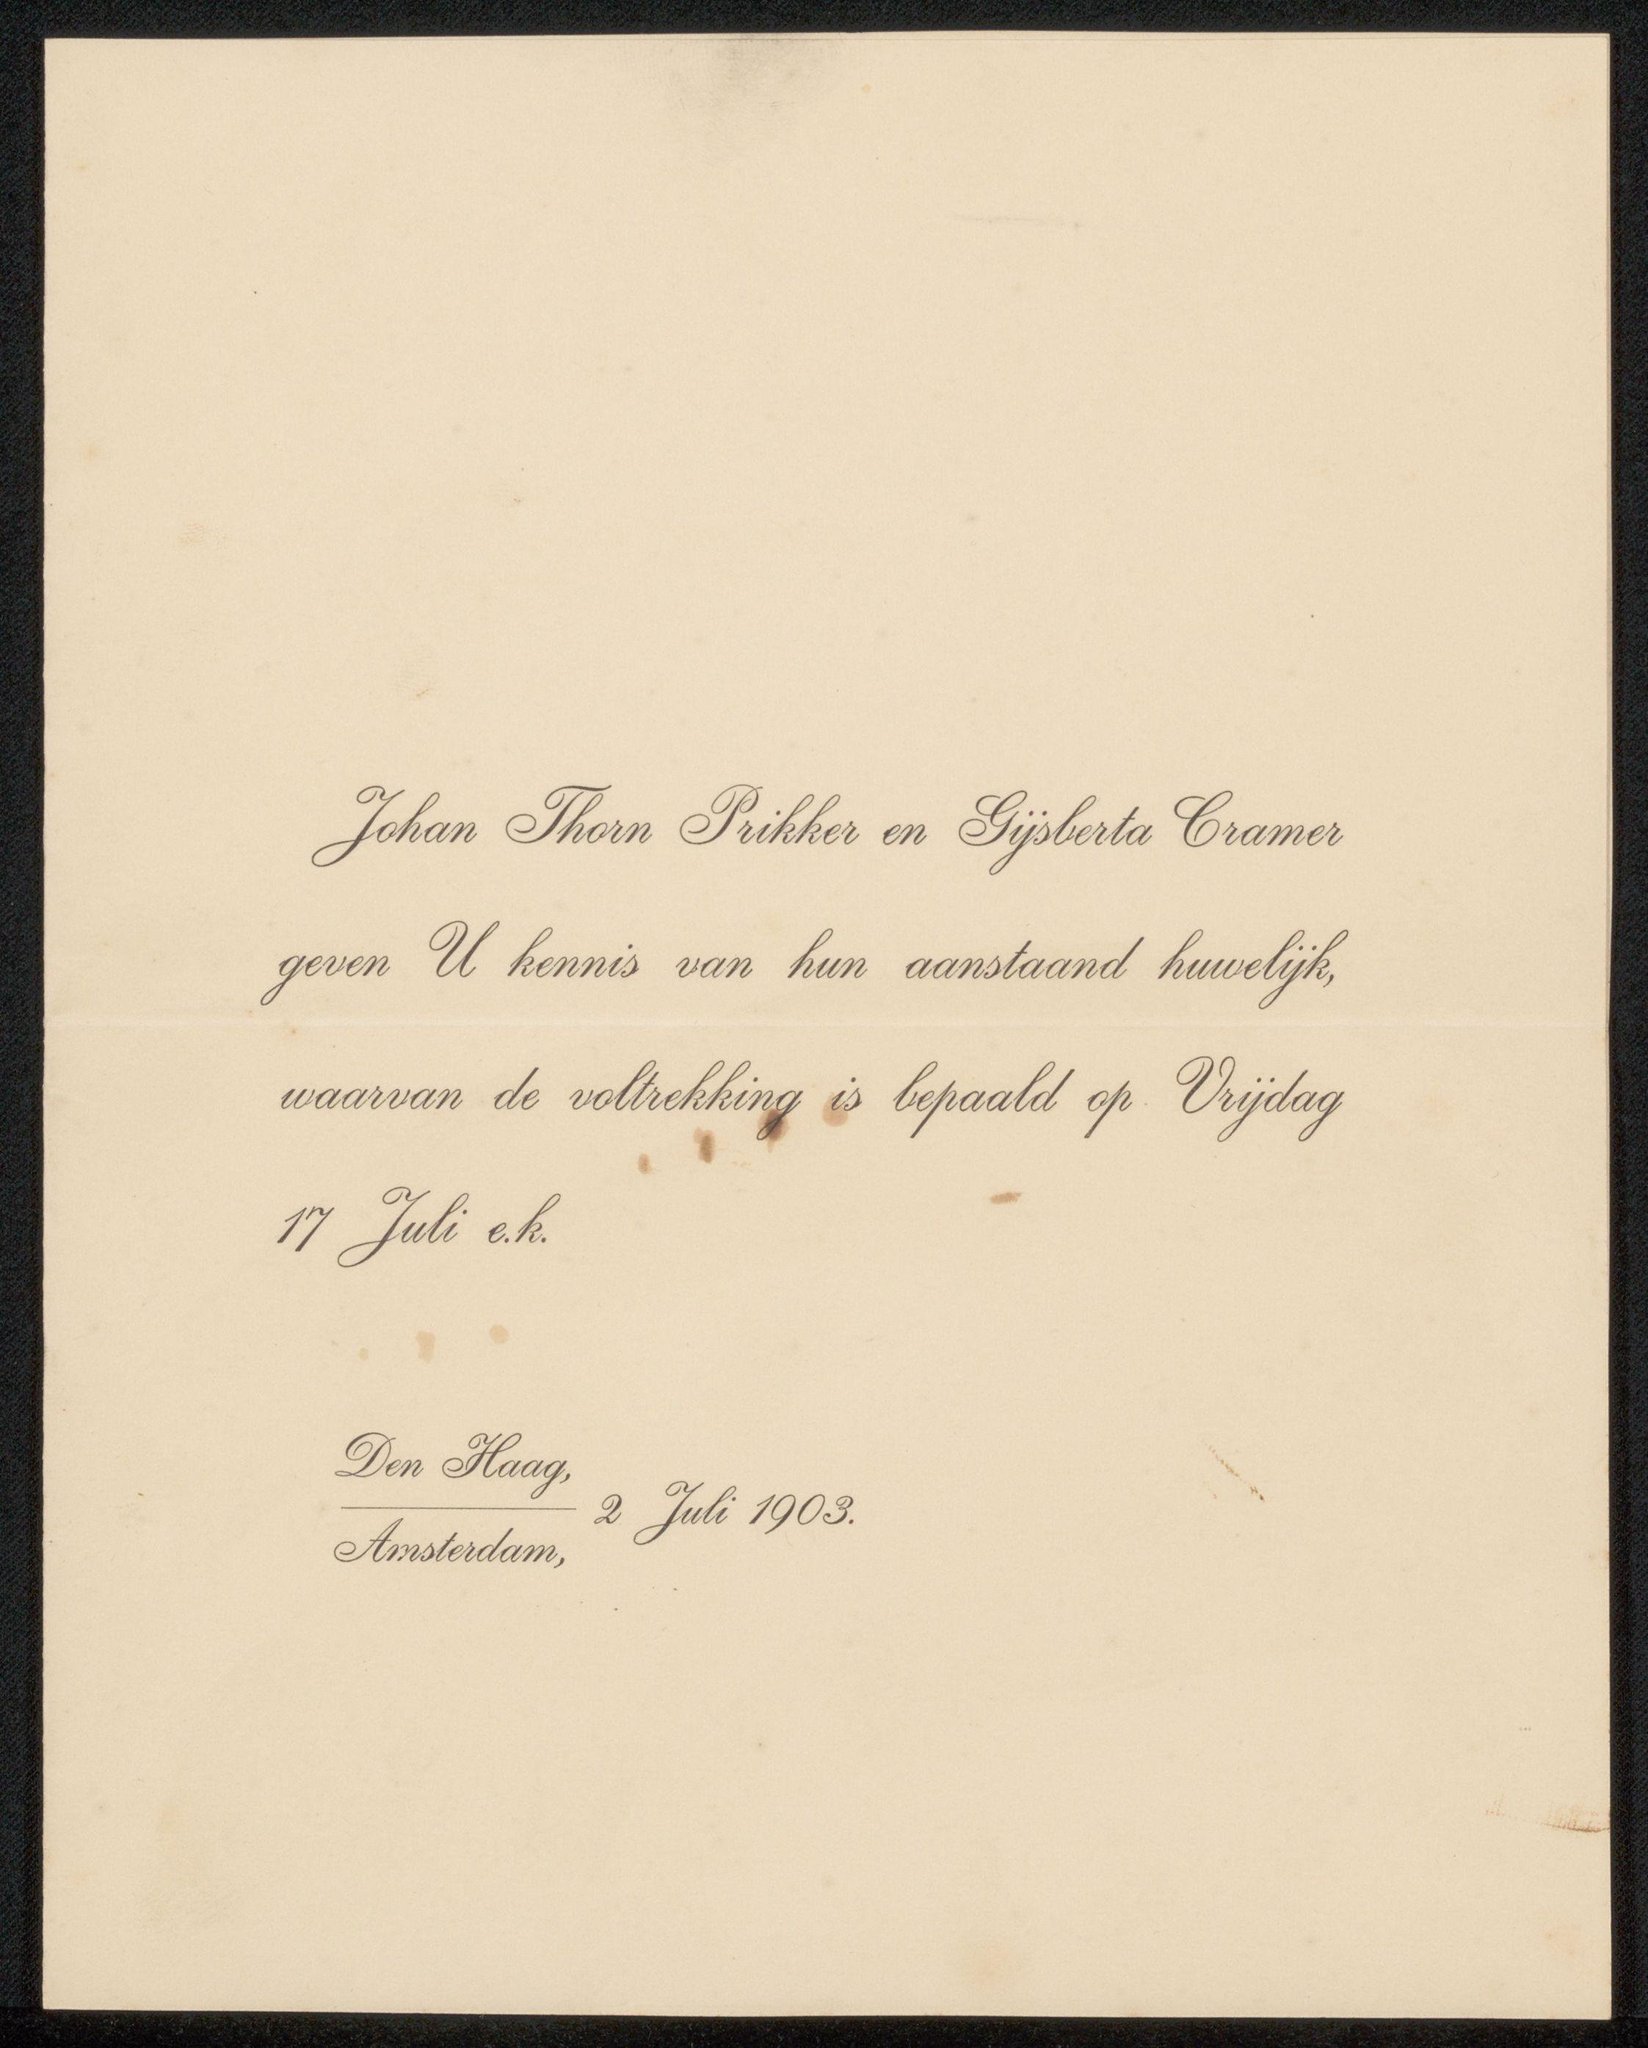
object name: wedding announcement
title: Huwelijksaankondiging aan Philip Zilcken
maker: Anonymous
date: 1903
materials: cardboard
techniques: printing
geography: the hague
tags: cologne, print maker, draughtsman, johan thorn prikker, painter, philip zilcken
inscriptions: collector's mark: ‘RPK’